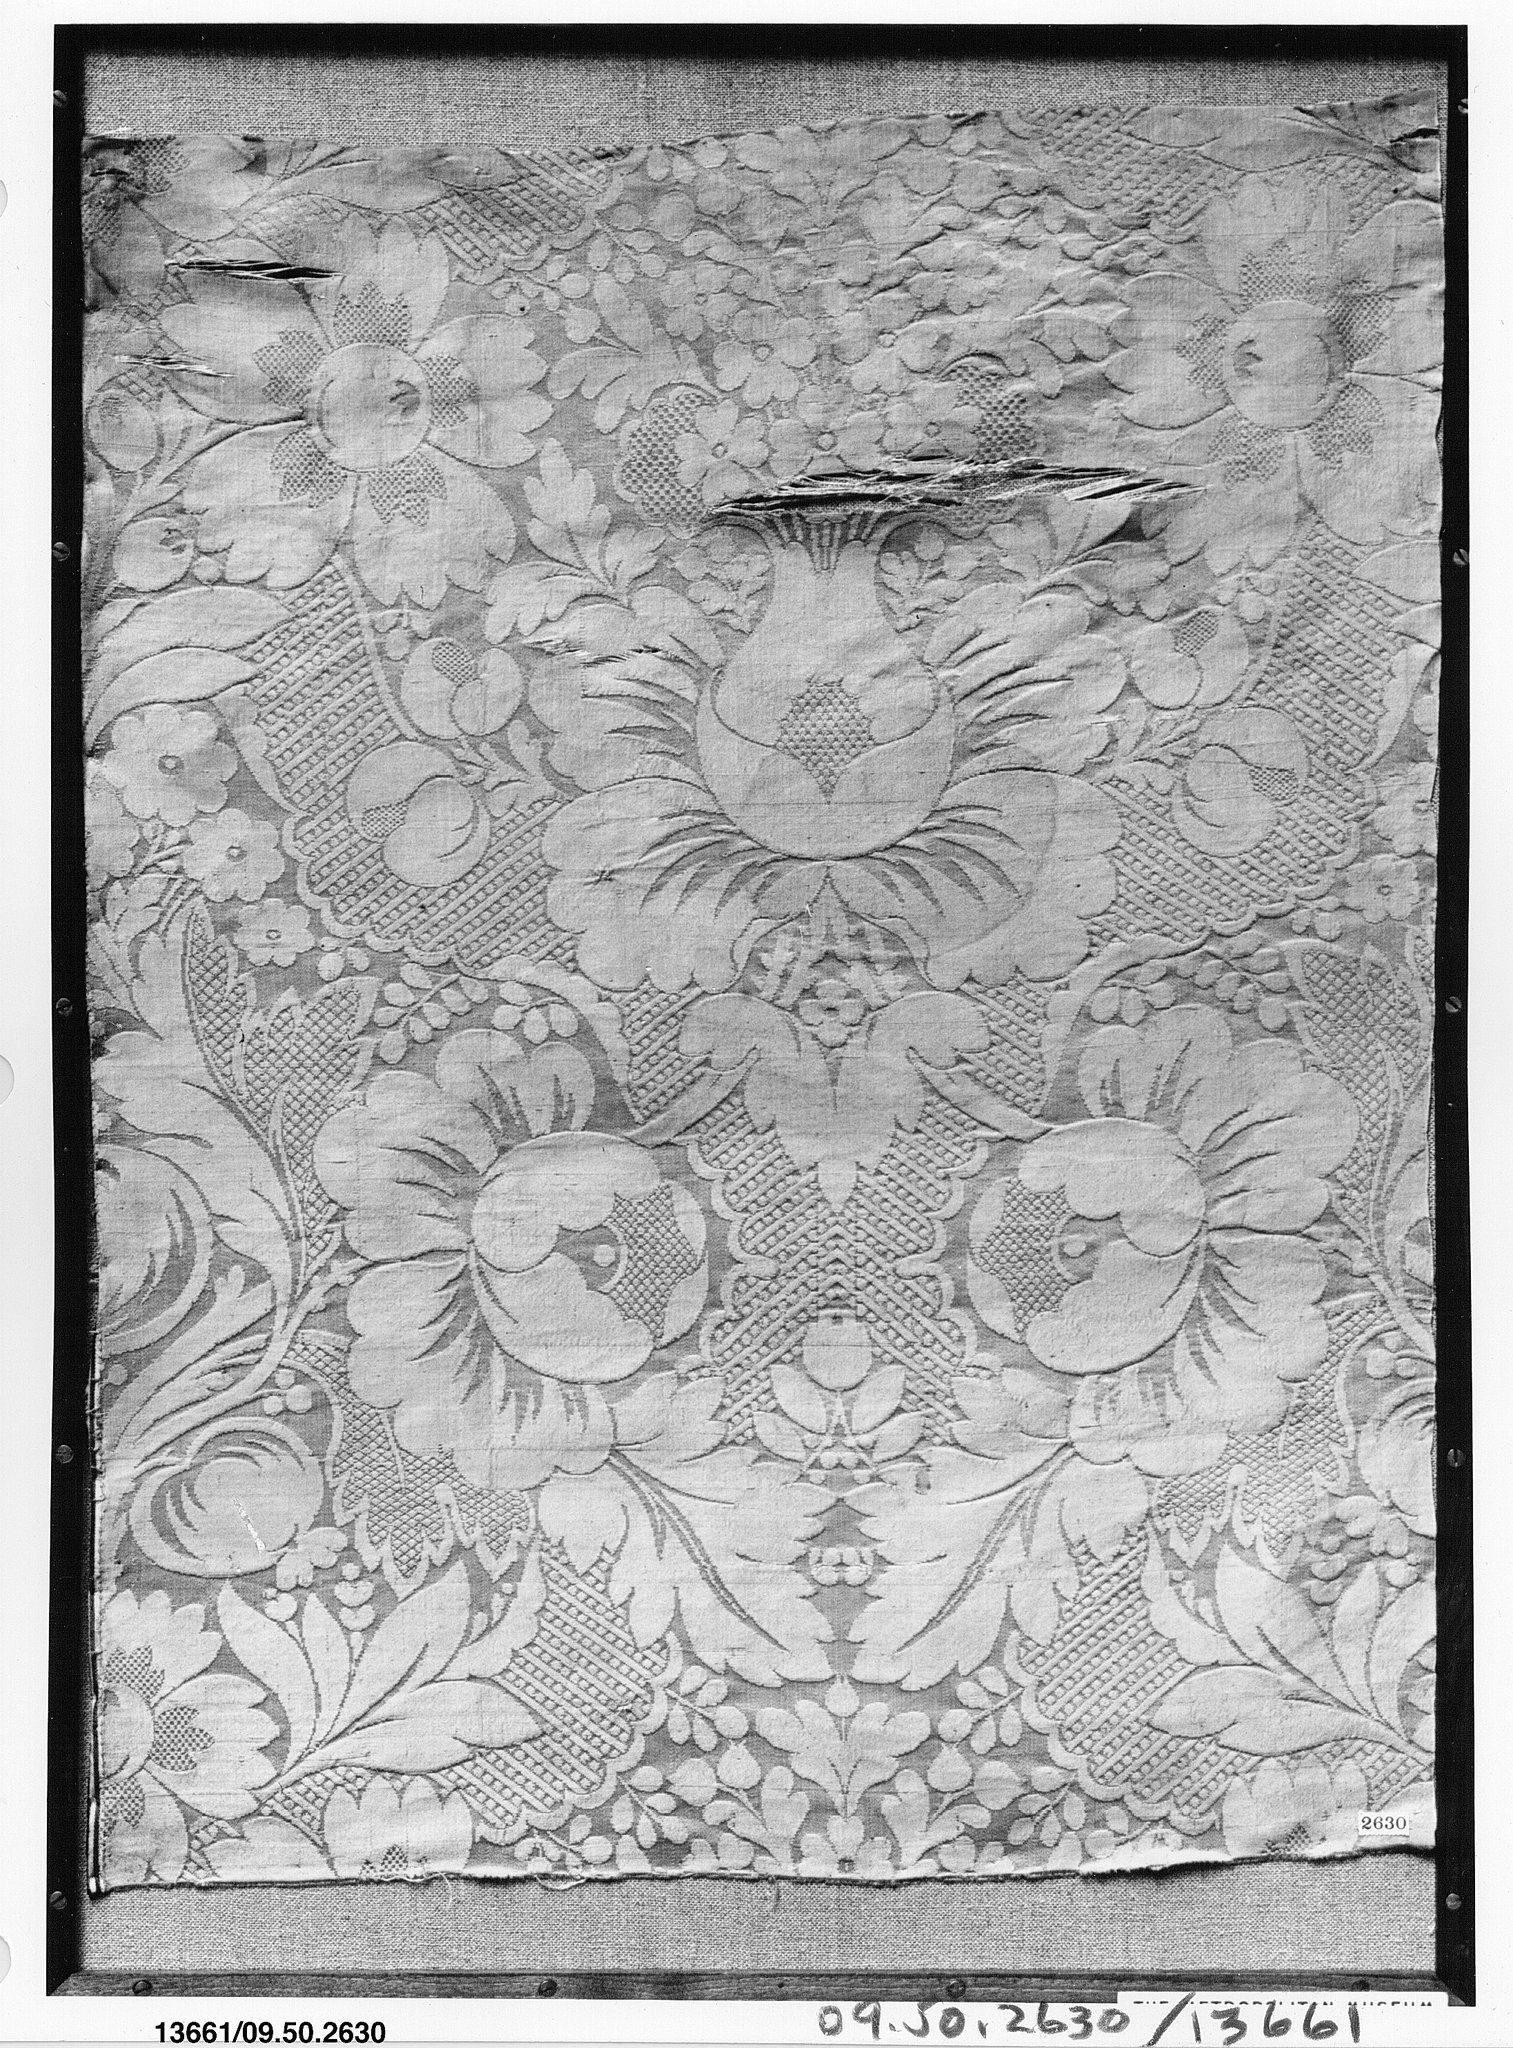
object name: piece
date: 1734-1766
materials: silk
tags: flowers,leaves